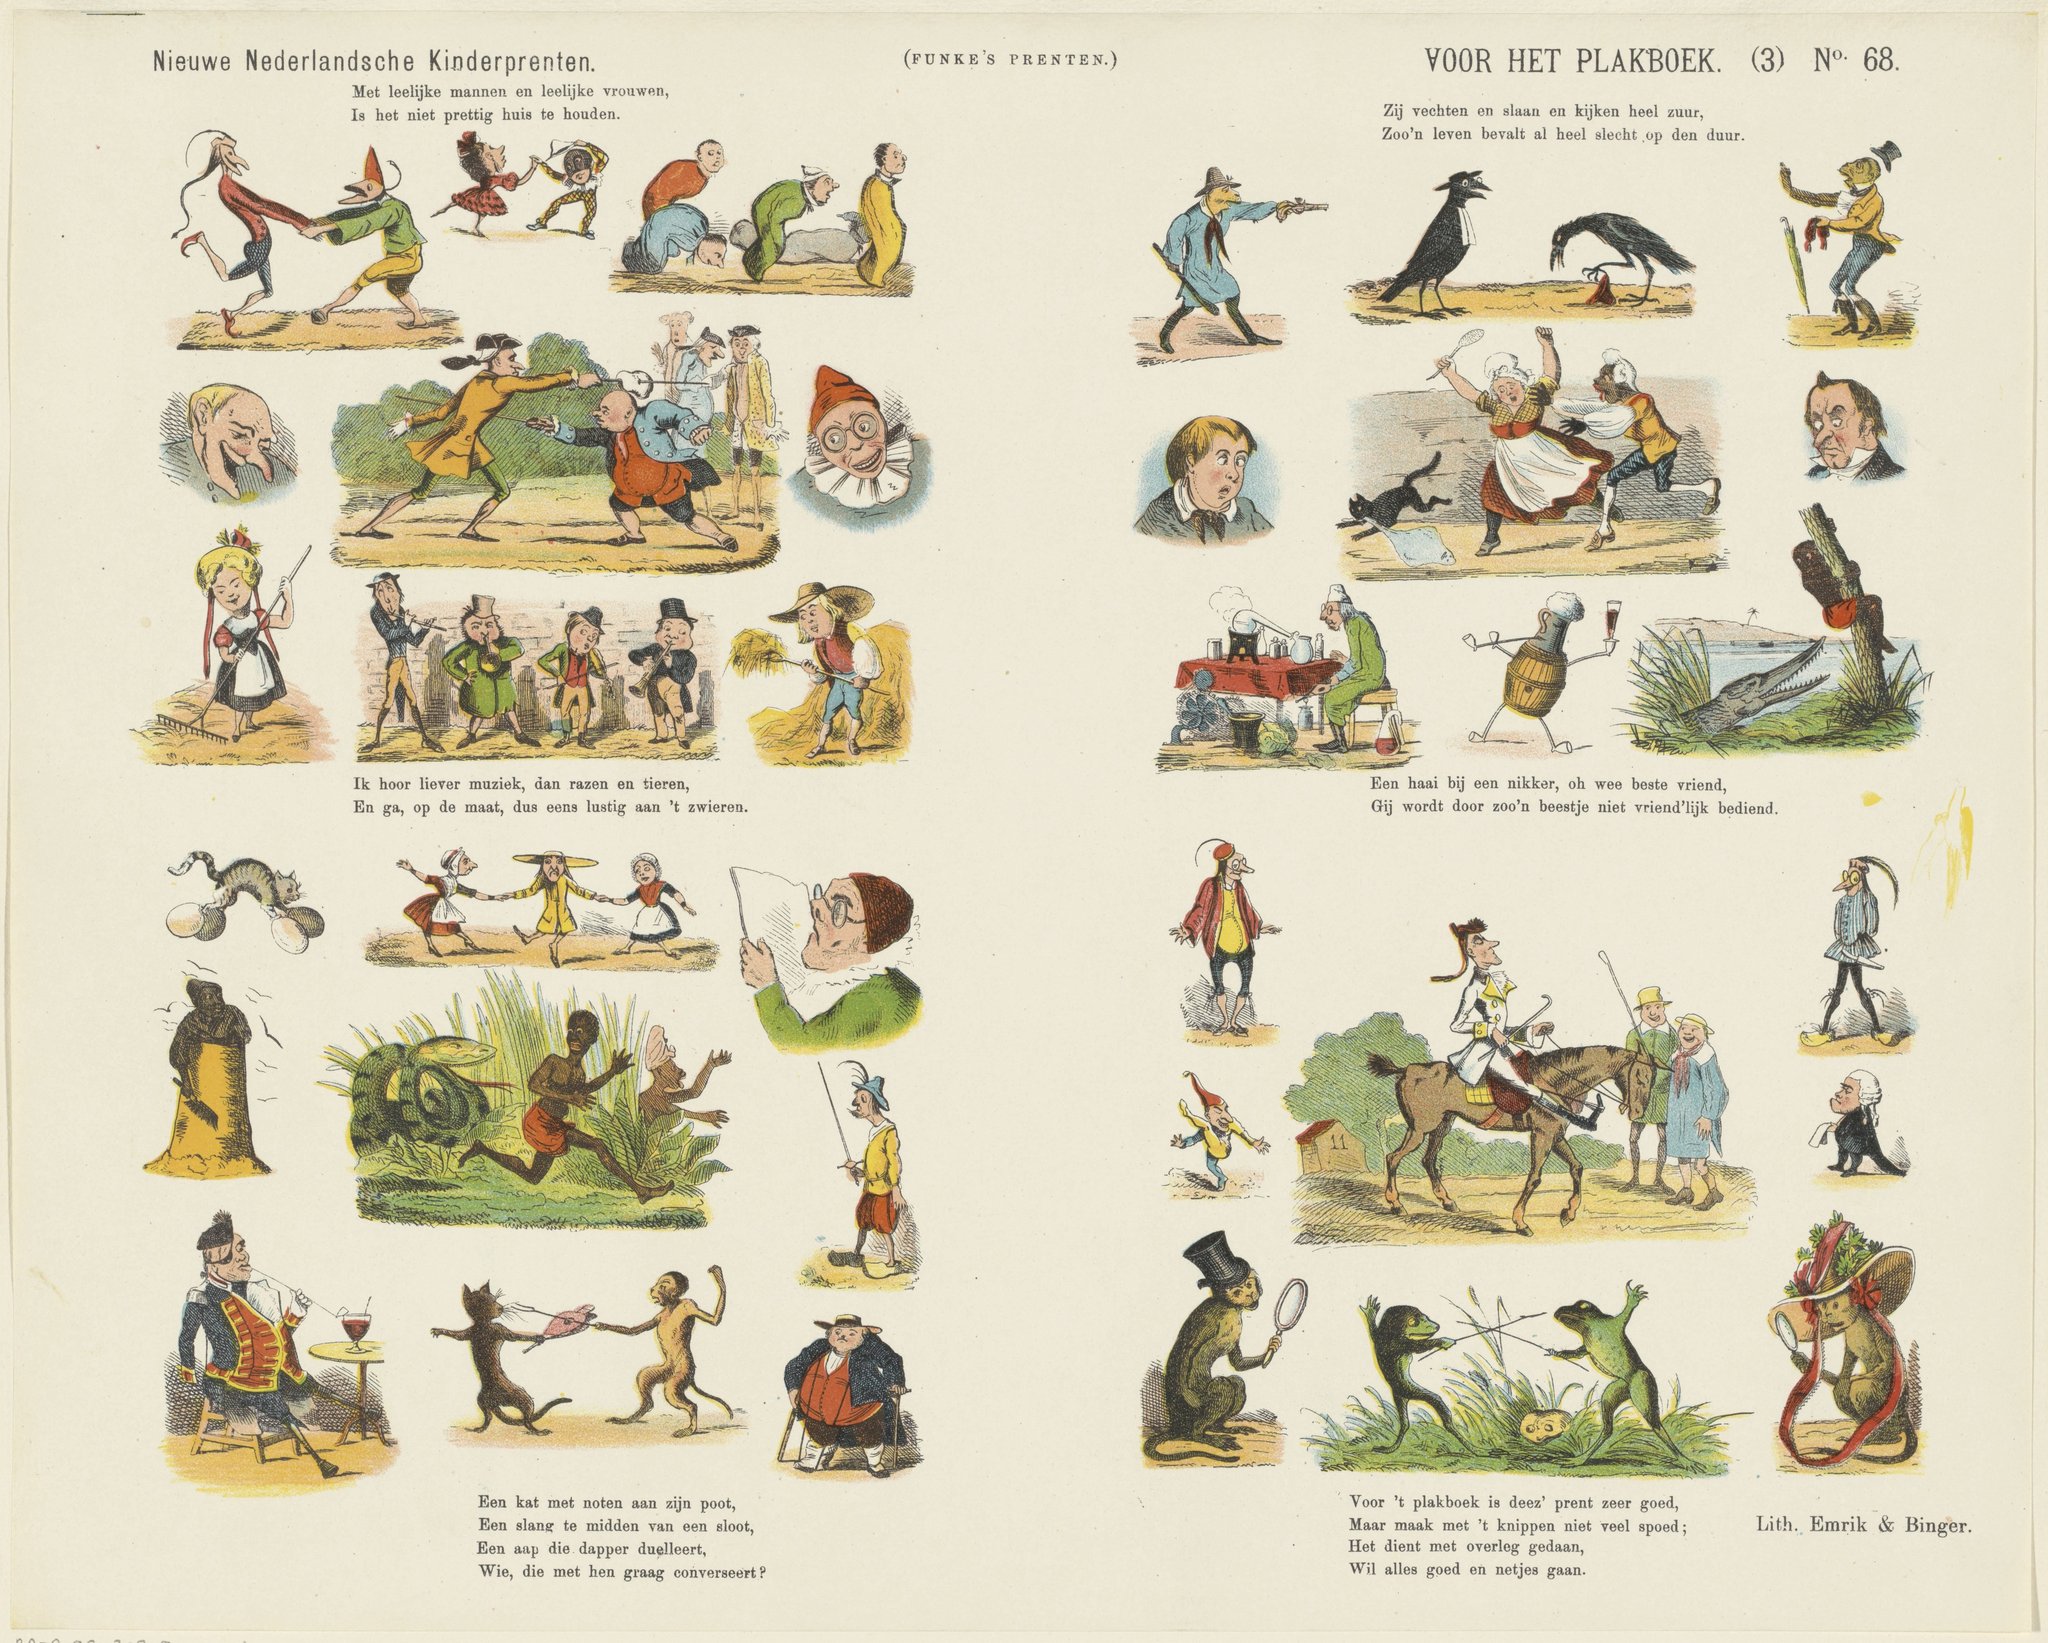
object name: popular print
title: Funke's prenten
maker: Anonymous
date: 1875-1919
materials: paper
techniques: lithograph, letterpress printing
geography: haarlem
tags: caricatures (human types), animals acting as human beings, characters (human types)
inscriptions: collector's mark: Lugt 2760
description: Blad met 35 voorstellingen van verschillende aard, waaronder voorstellingen van karikaturale figuren en dieren die zich als mensen gedragen. Tussen de afbeeldingen zes versjes. Genummerd rechtsboven: No. 68.